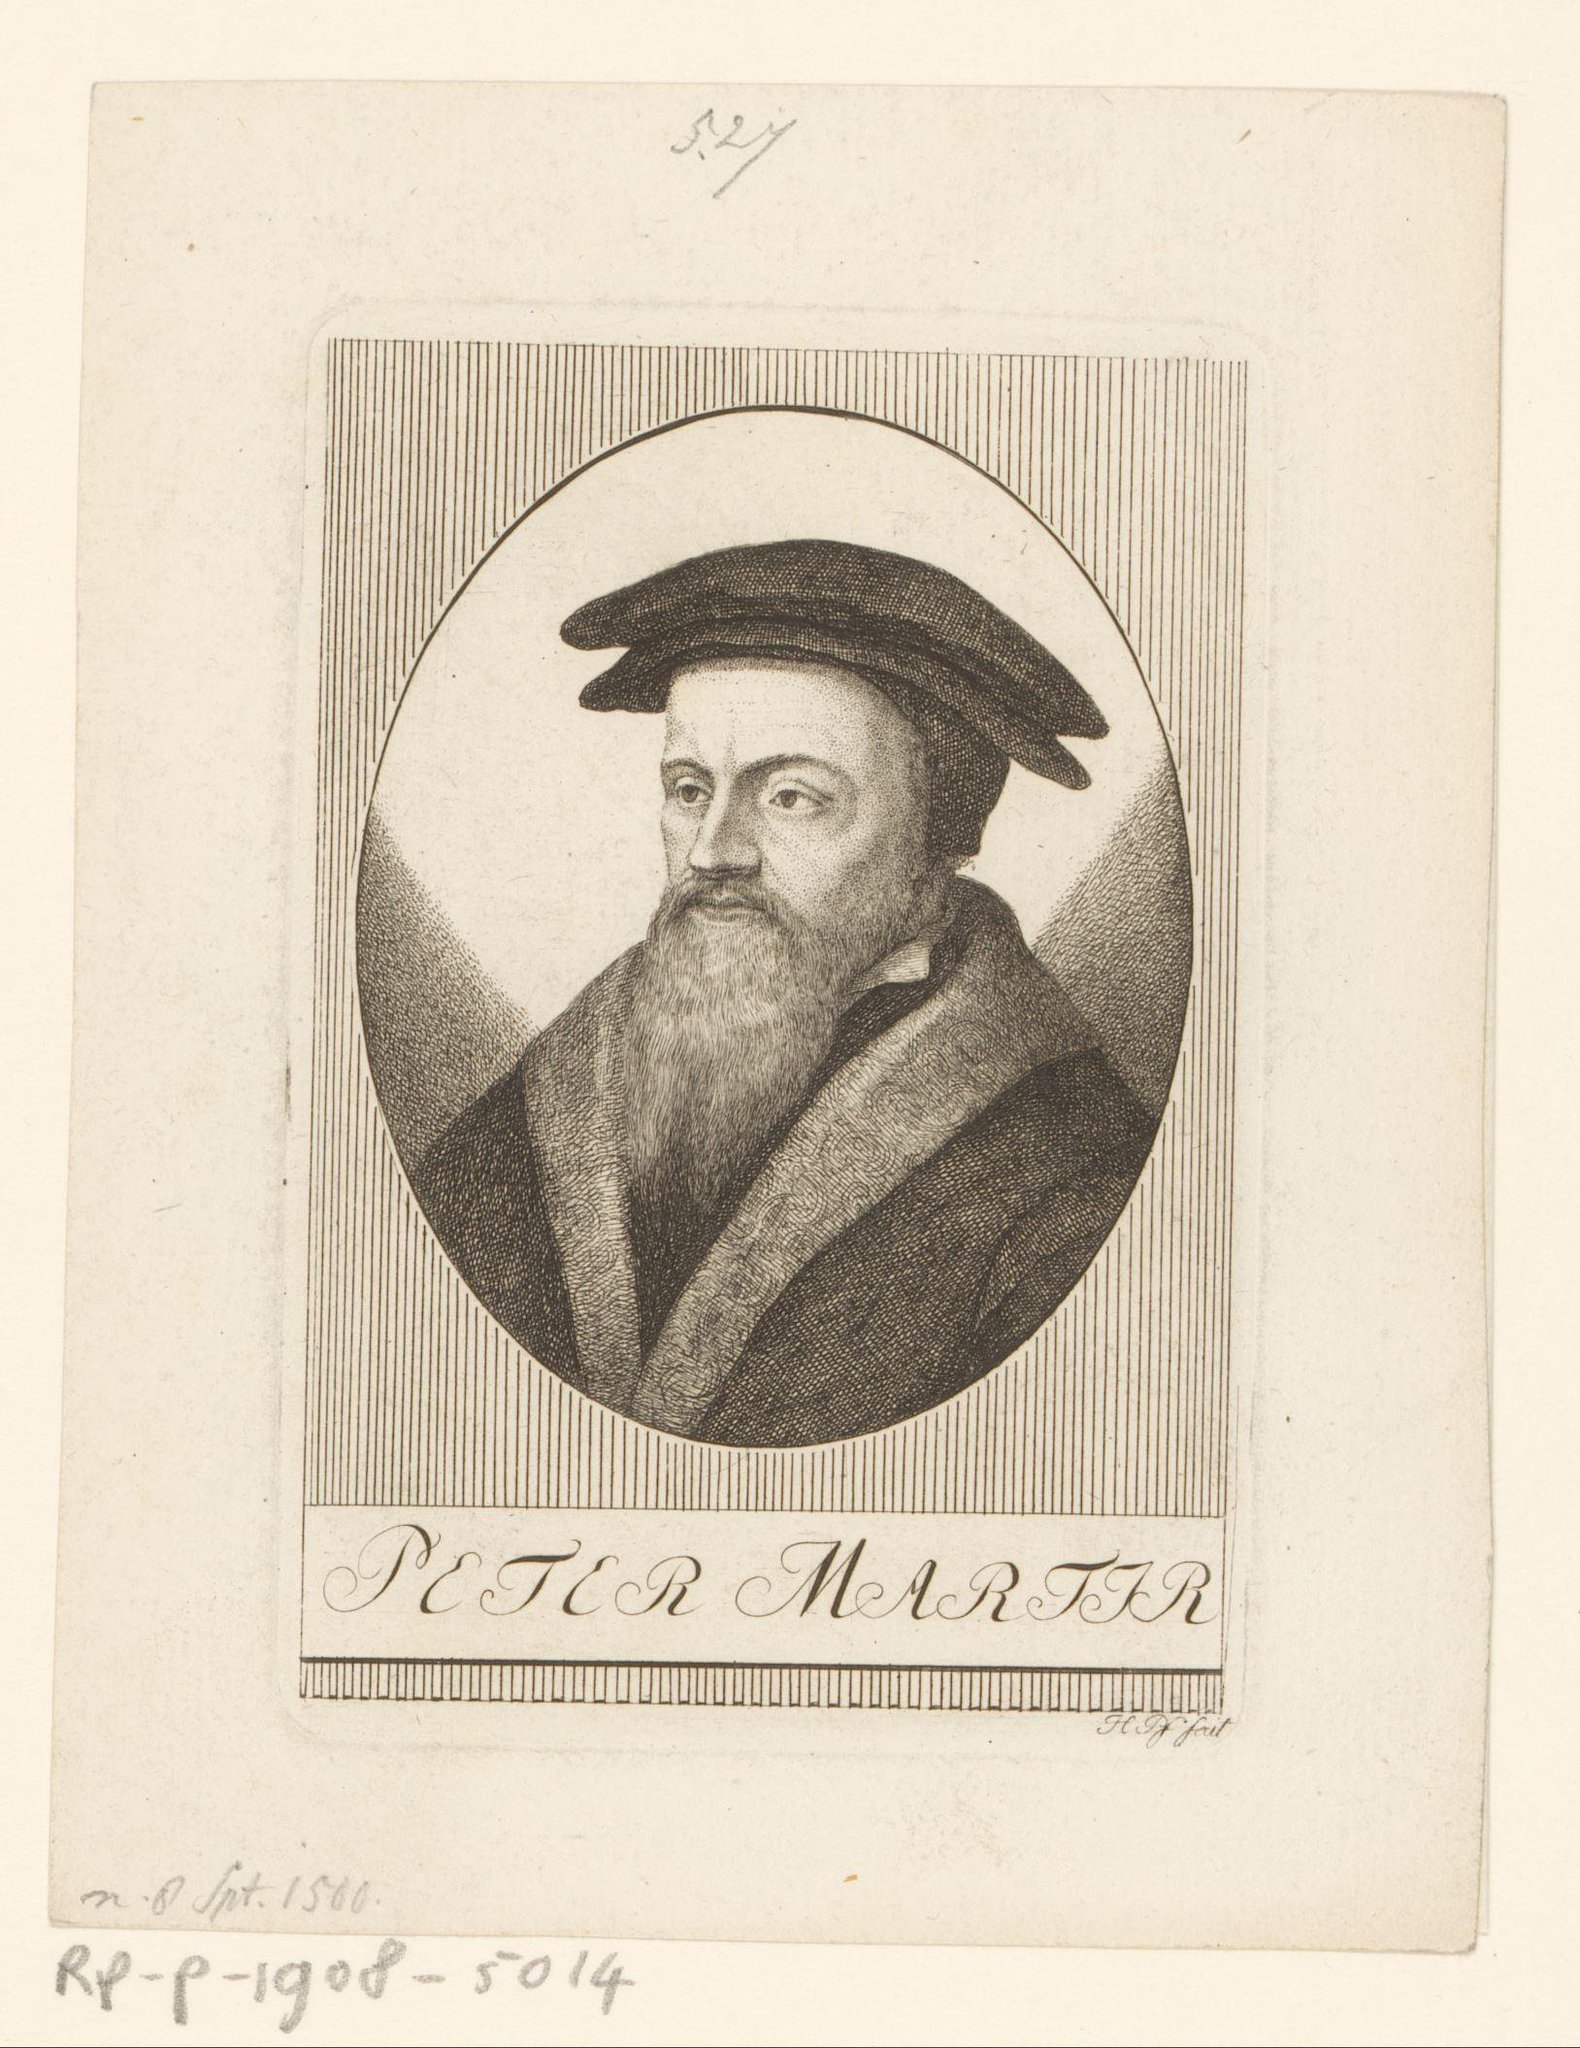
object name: print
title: Portret van Petrus Martyr Anglerius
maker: heinrich pfenninger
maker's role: print maker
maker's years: 1749-1815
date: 1759-1815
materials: paper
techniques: etching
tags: historical persons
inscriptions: date, collector's mark: Lugt 2228